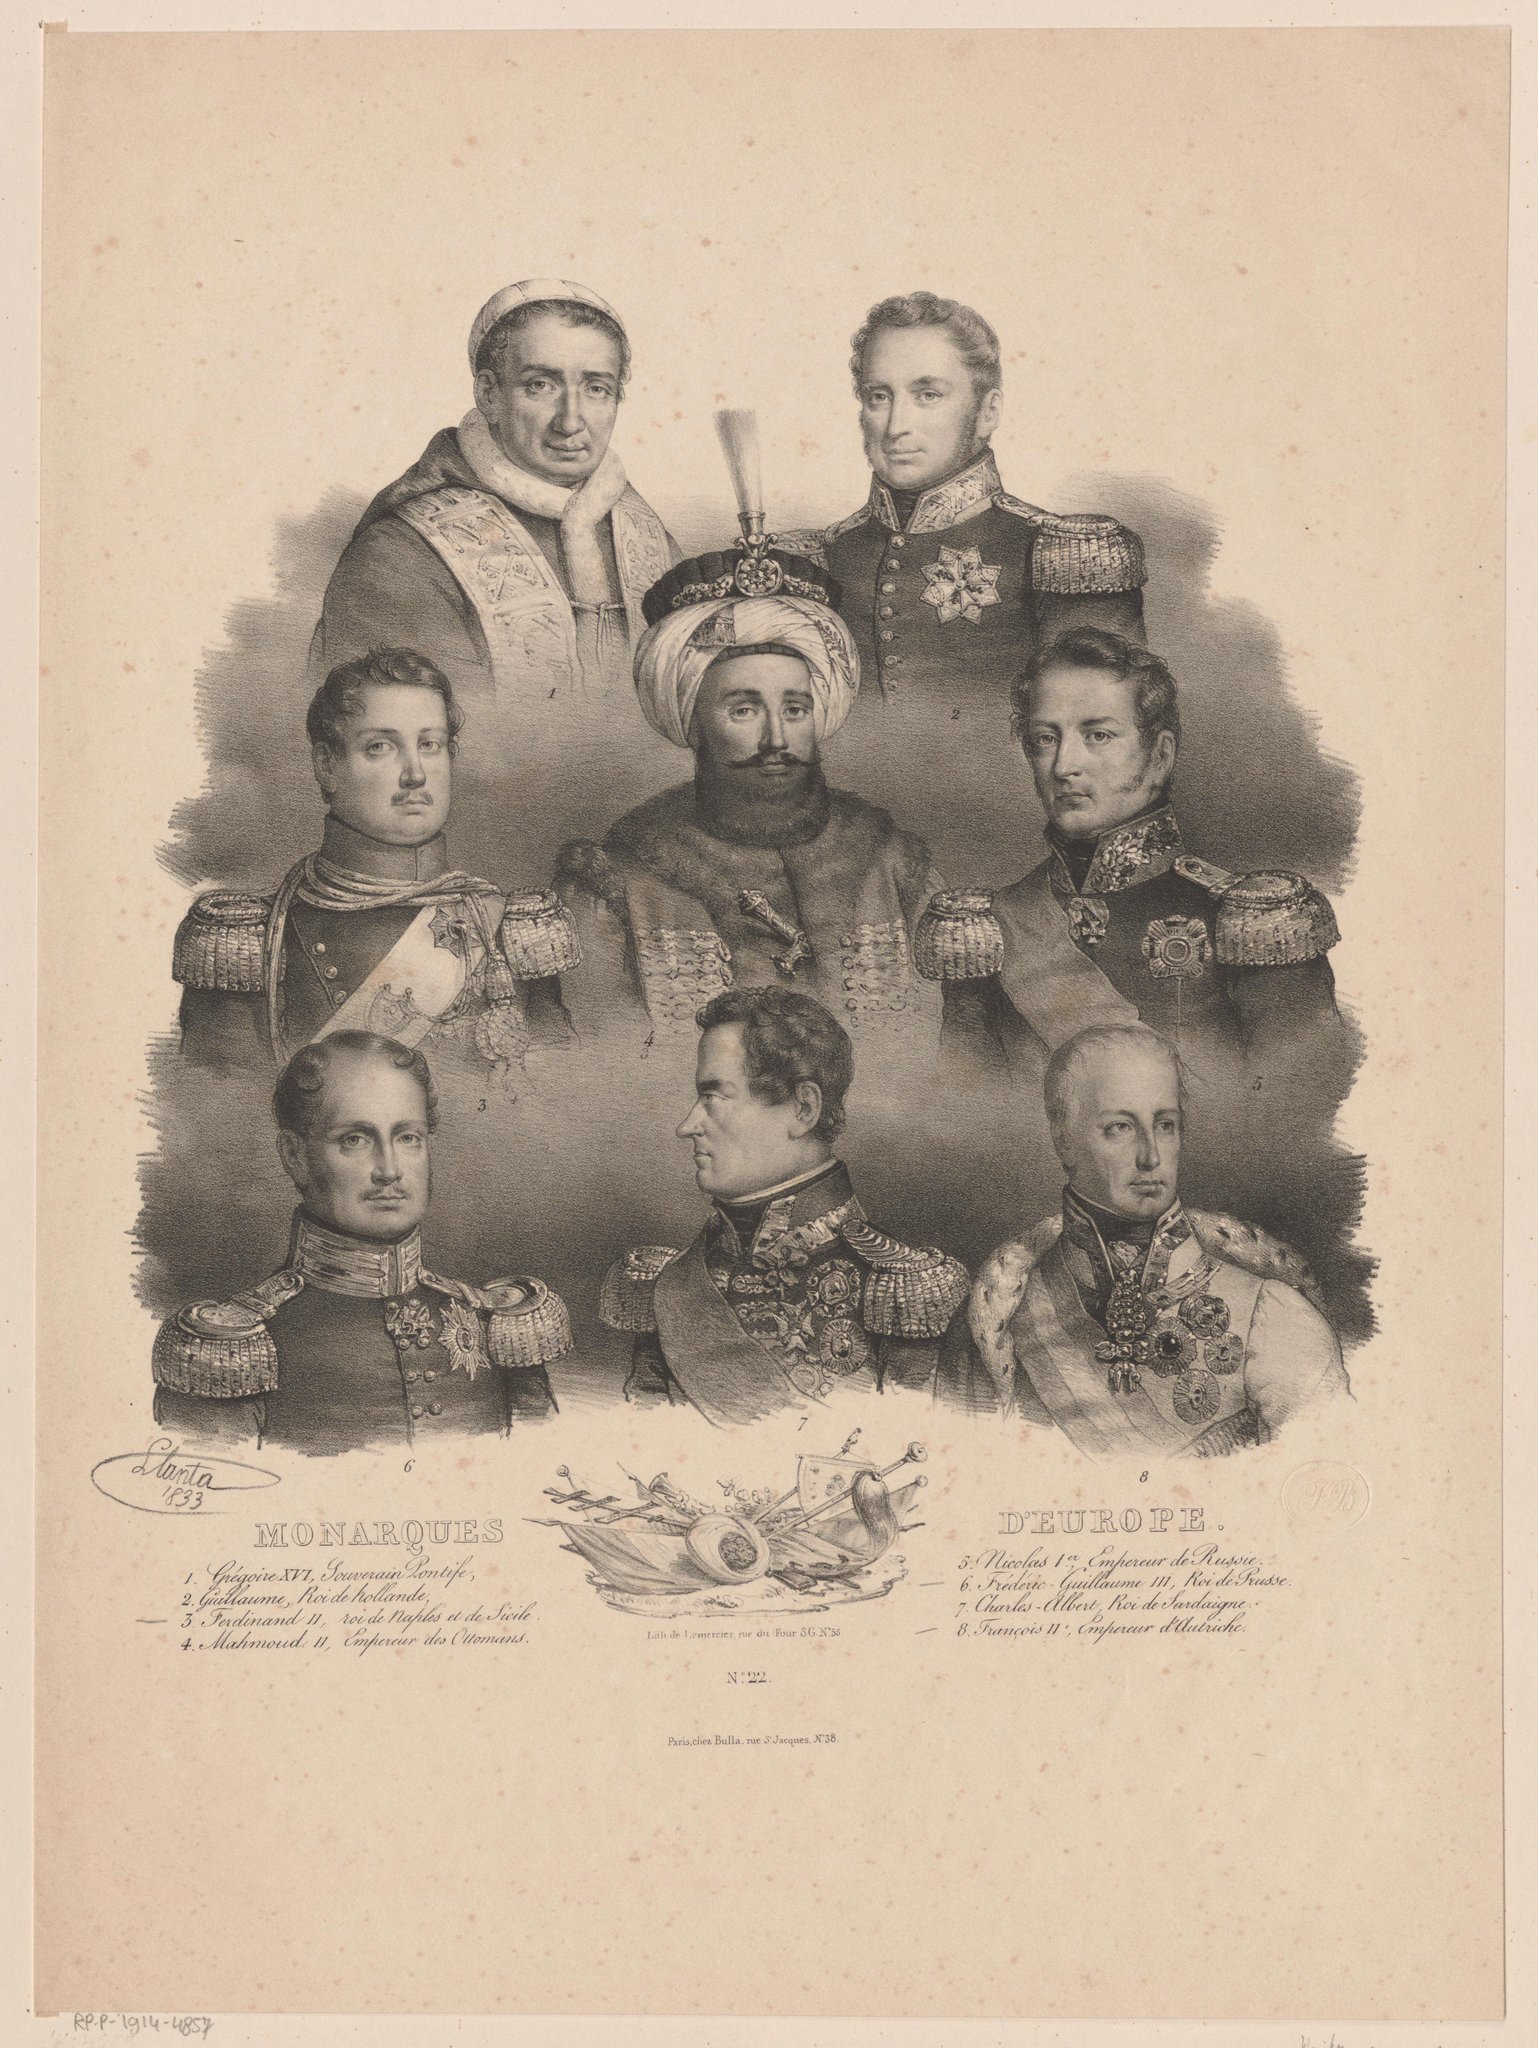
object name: print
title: Portretten van acht Europese vorsten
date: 1833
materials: paper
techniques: lithograph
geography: paris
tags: rome, the hague, william i of the netherlands, caserta, vienna, frans ii (rooms-duits keizer), frederik willem iii koning van pruisen, historical persons, ruler, sovereign, king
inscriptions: collector's mark: Lugt 2228, check stamp: Lugt 4088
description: Portretten van paus Gregorius XVI, Willem I (koning der Nederlanden), Ferdinand II (koning der Beide Siciliën), Mahmut II (sultan van het Ottomaanse Rijk), Nicolaas I Pavlovitsj (tsaar van Rusland), Frederik Willem III (koning van Pruisen), Karel Albert (koning van Sardinië) en Frans II (Rooms-Duits keizer). Linksonder en rechtsonder een verklarende lijst.